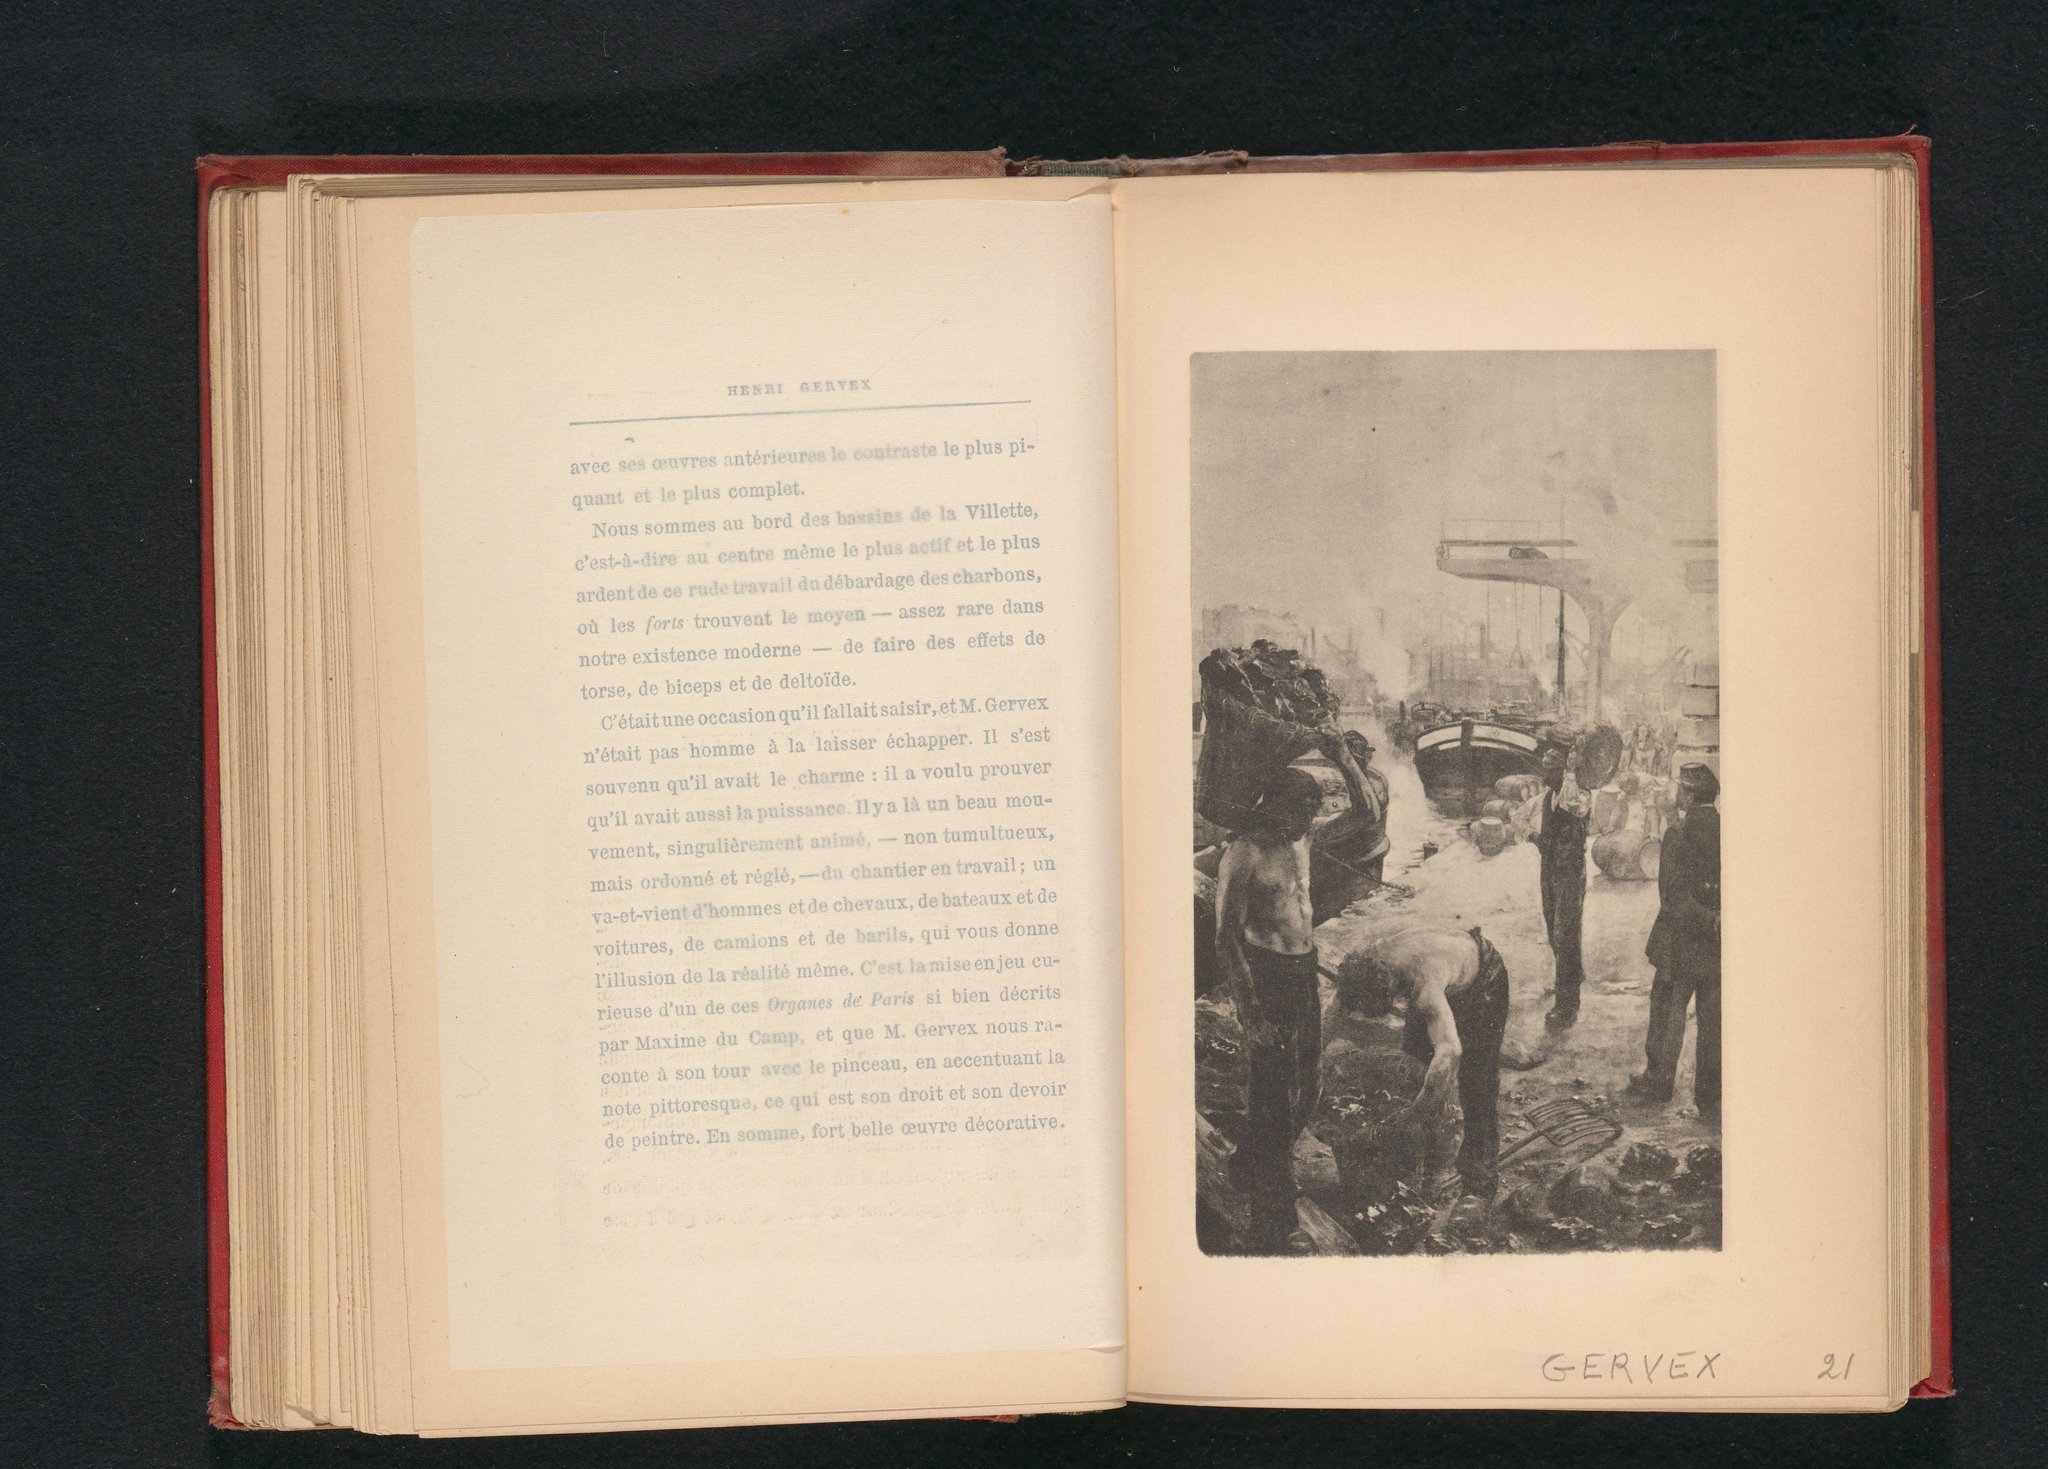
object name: reproduction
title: Fotoreproductie van een schilderij, voorstellende een gezicht op een kade met havenwerkers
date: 1872-1882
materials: paper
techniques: photograph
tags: dock labourer, pier, quay, wharf